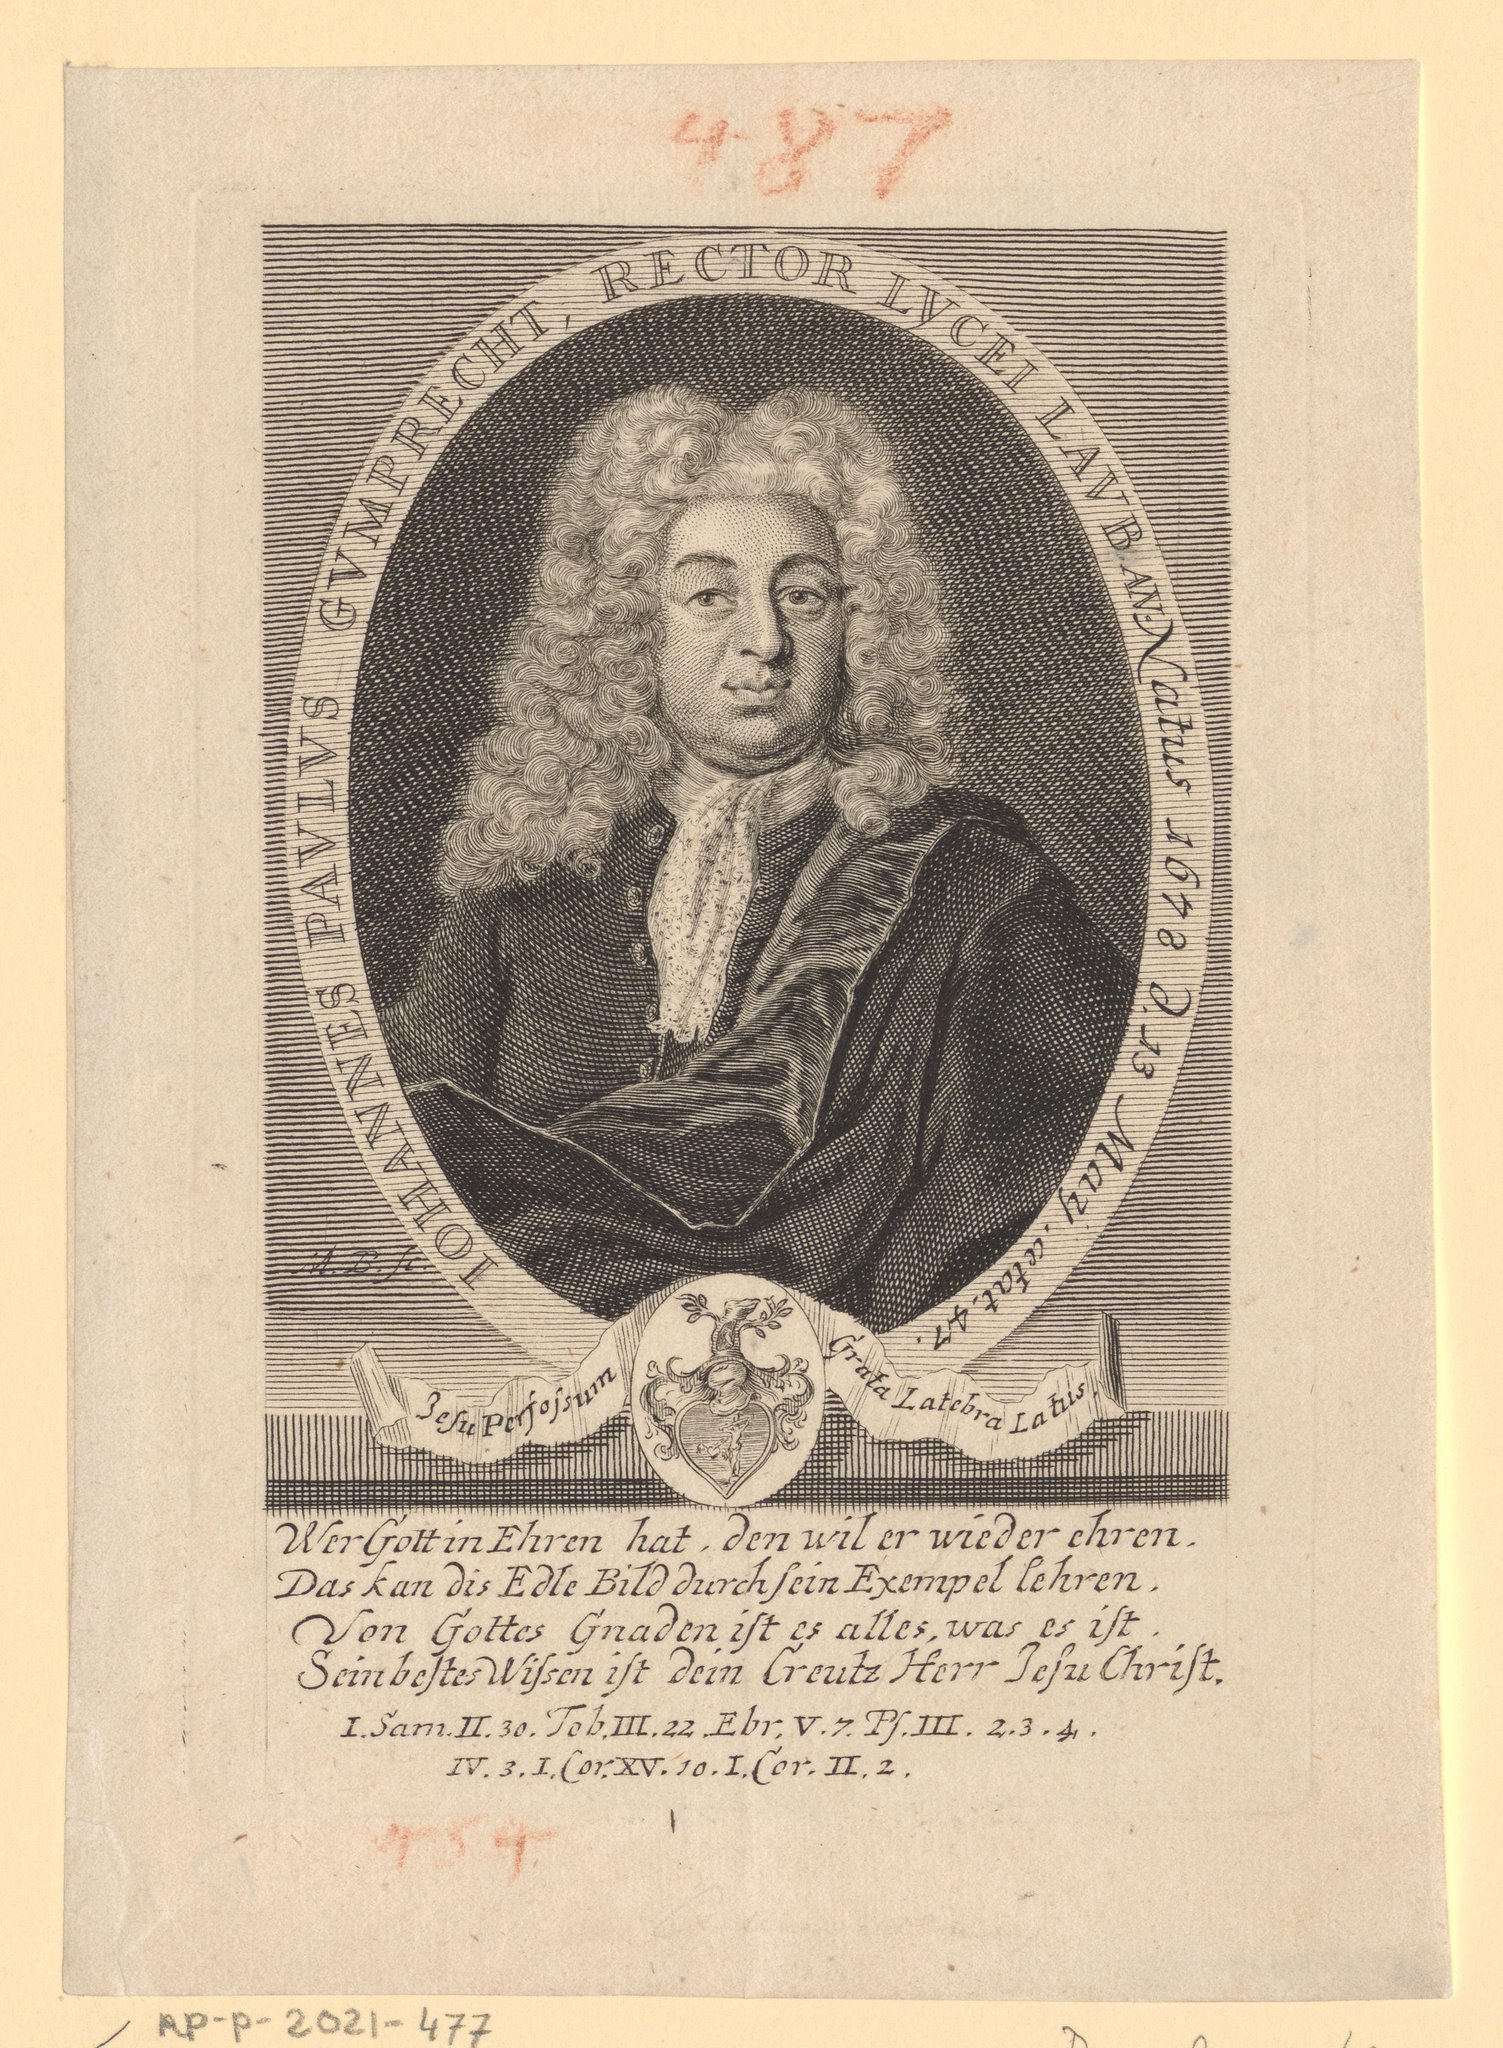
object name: print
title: Portret van Johann Paul Gumprecht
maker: martin bernigeroth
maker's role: print maker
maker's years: 1670-1733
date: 1688-1733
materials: paper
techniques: engraving, etching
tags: historical persons, armorial bearing, heraldry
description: Tekst in het Duits in de ondermarge en in het Latijn de omlijsting.